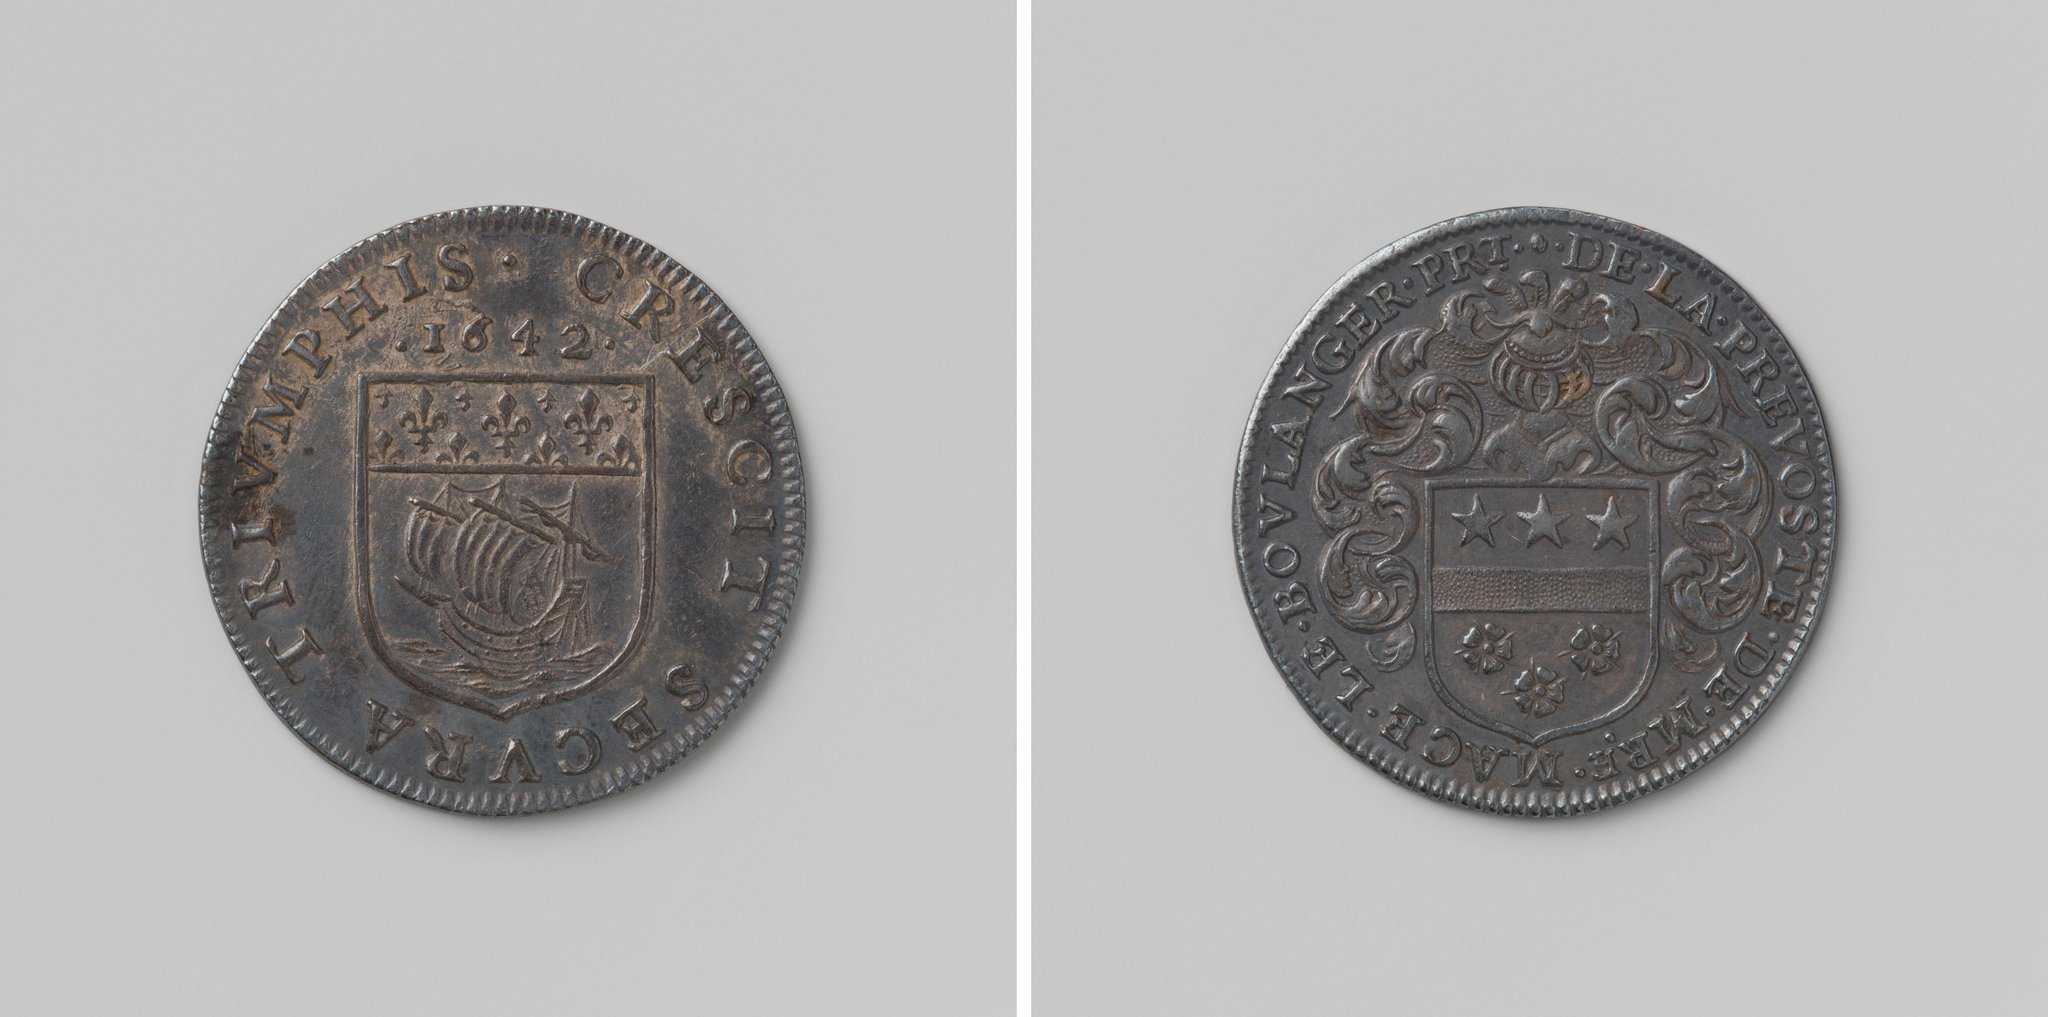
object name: jeton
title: Koopmansgilde te Parijs, rekenpenning ter ere van provoost Mace de la Boulanger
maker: Anonymous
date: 1642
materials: silver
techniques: striking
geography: paris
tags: paris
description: Zilveren penning. Voorzijde: wapenschild onder jaartal binnen omschrift. Keerzijde: gehelmd wapenschild binnen omschrift